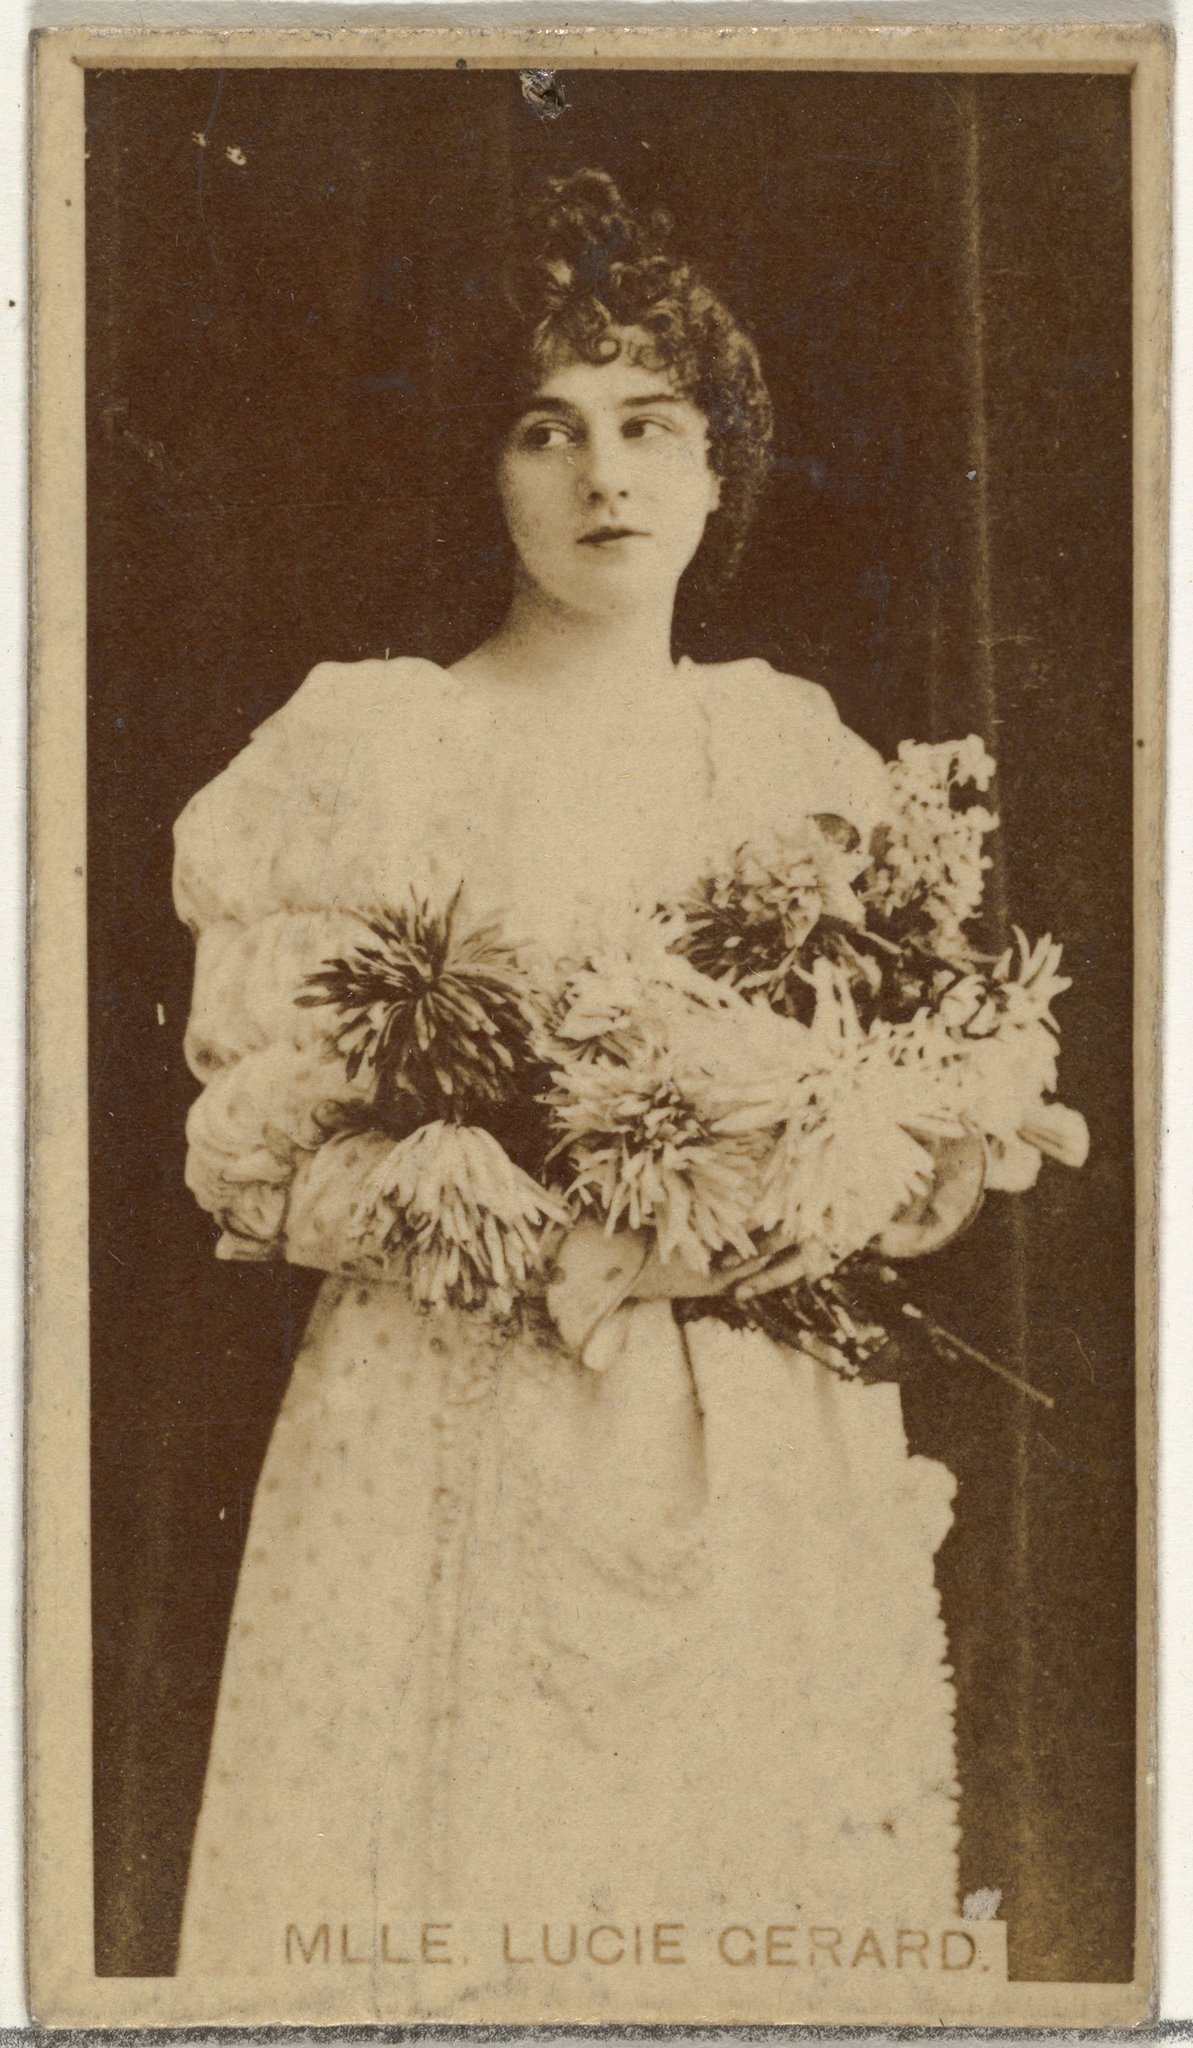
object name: photograph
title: Mlle. Lucie Gerard, from the Actors and Actresses series (N145-8) issued by Duke Sons & Co. to promote Duke Cigarettes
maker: w. duke, sons & co.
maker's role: publisher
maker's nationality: american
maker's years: 1870-1920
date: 1891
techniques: albumen silver print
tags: portraits,women,actresses